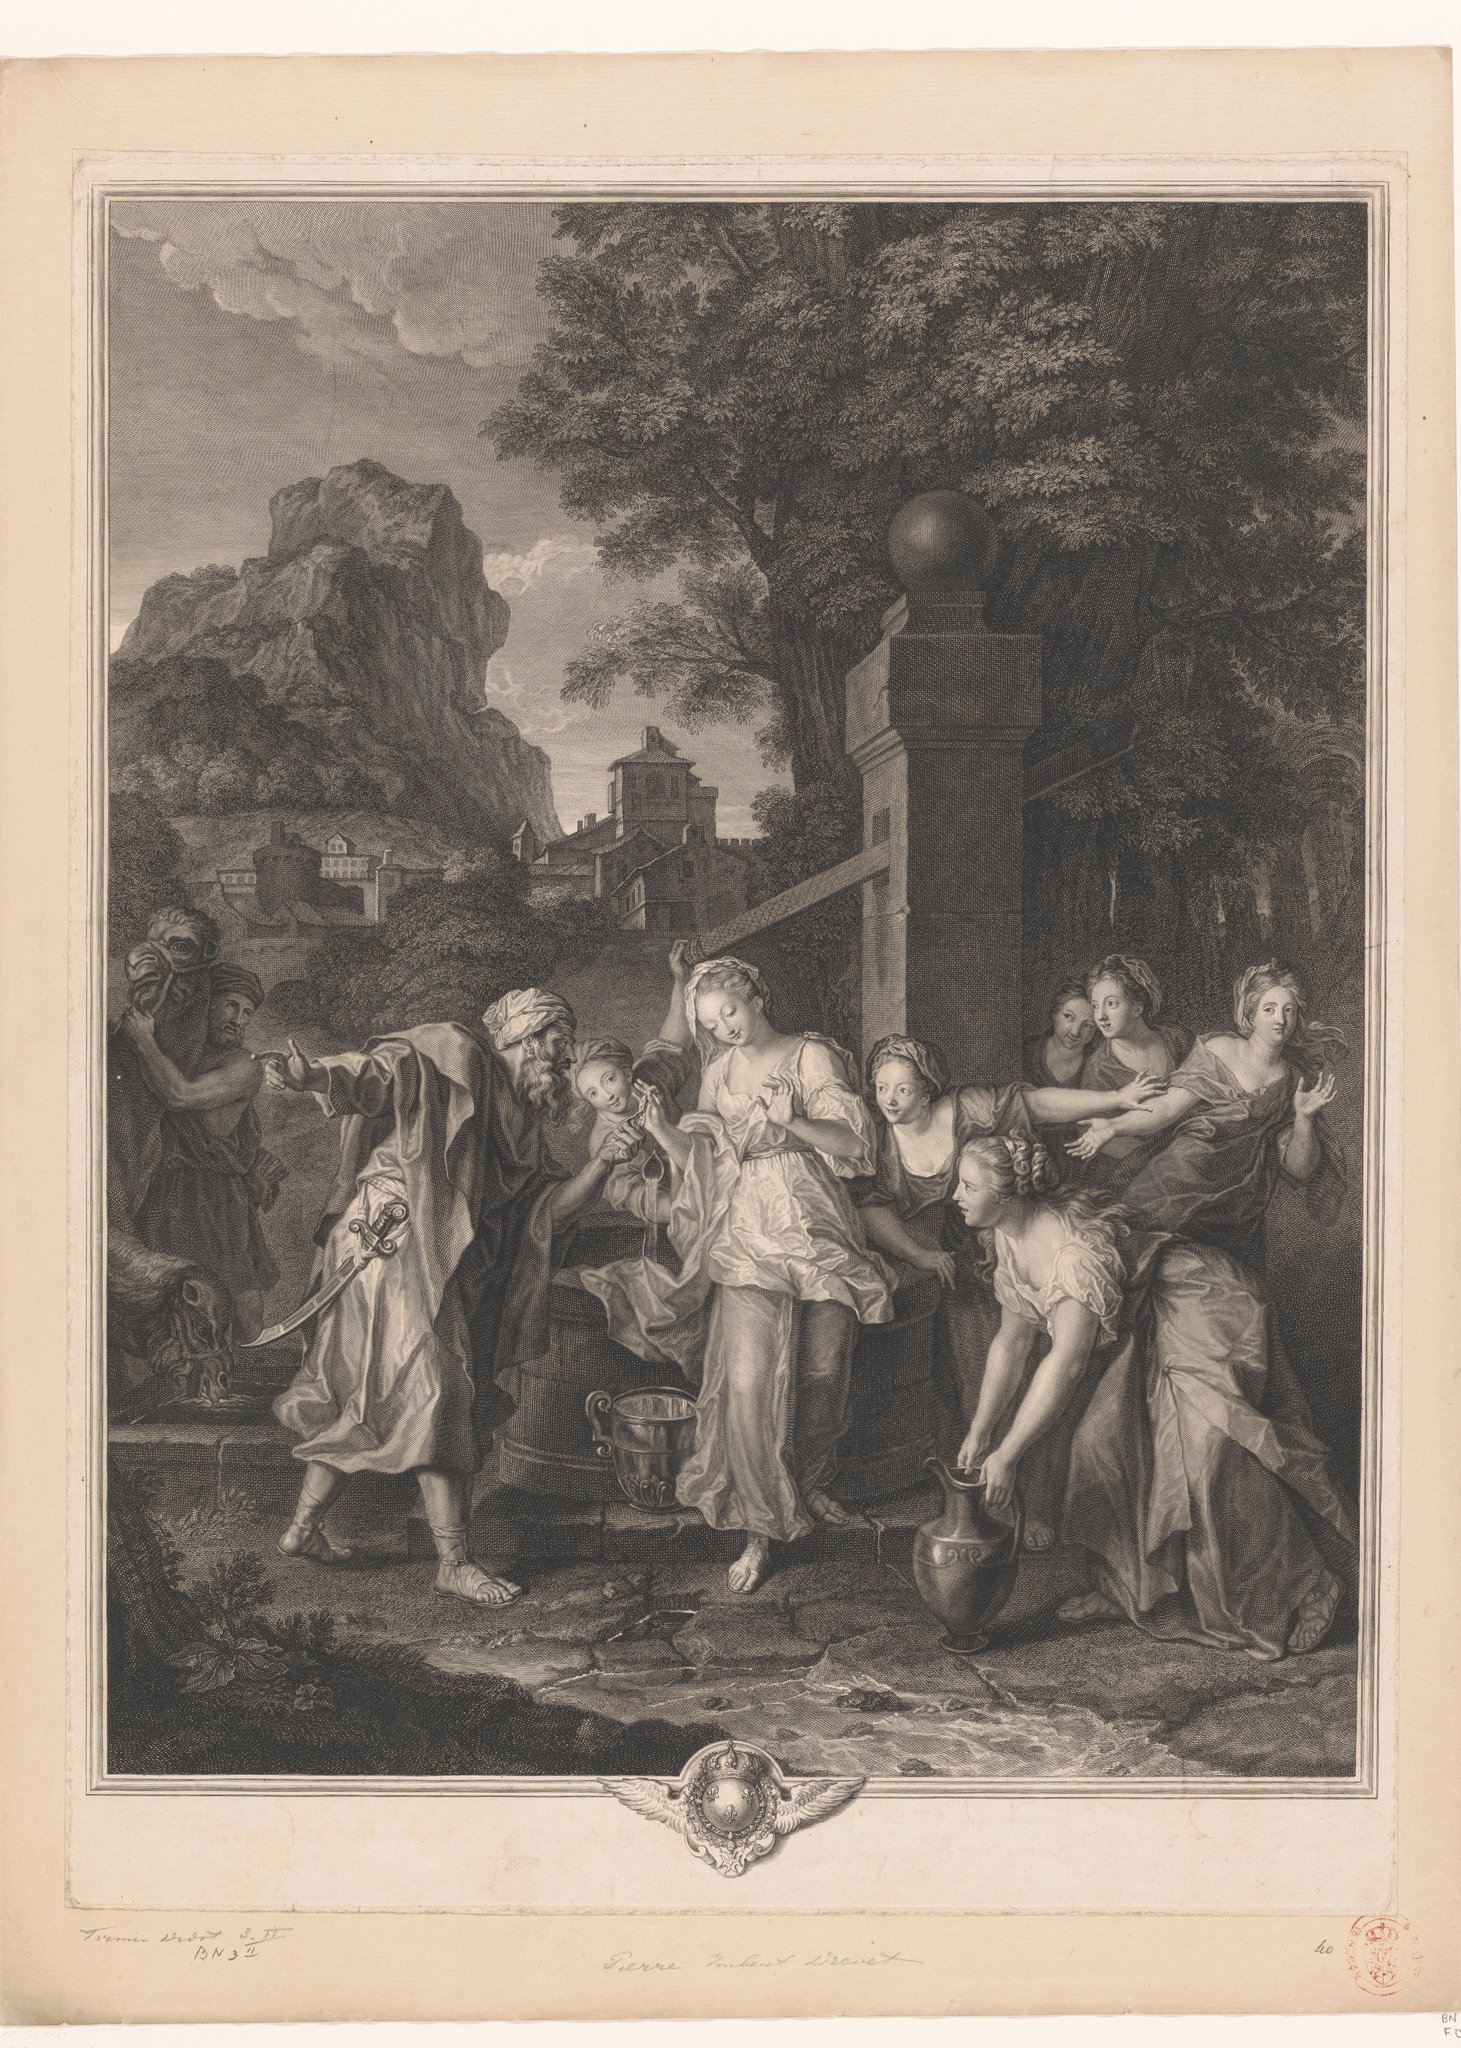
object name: print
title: Rebacca ontvangt geschenken van Eliezer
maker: pierre imbert drevet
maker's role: print maker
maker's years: 1697-1739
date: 1707-1739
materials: paper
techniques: engraving, etching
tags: rebekah receives ear-rings and golden bracelets from eliezer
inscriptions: collector's mark: Lugt 240